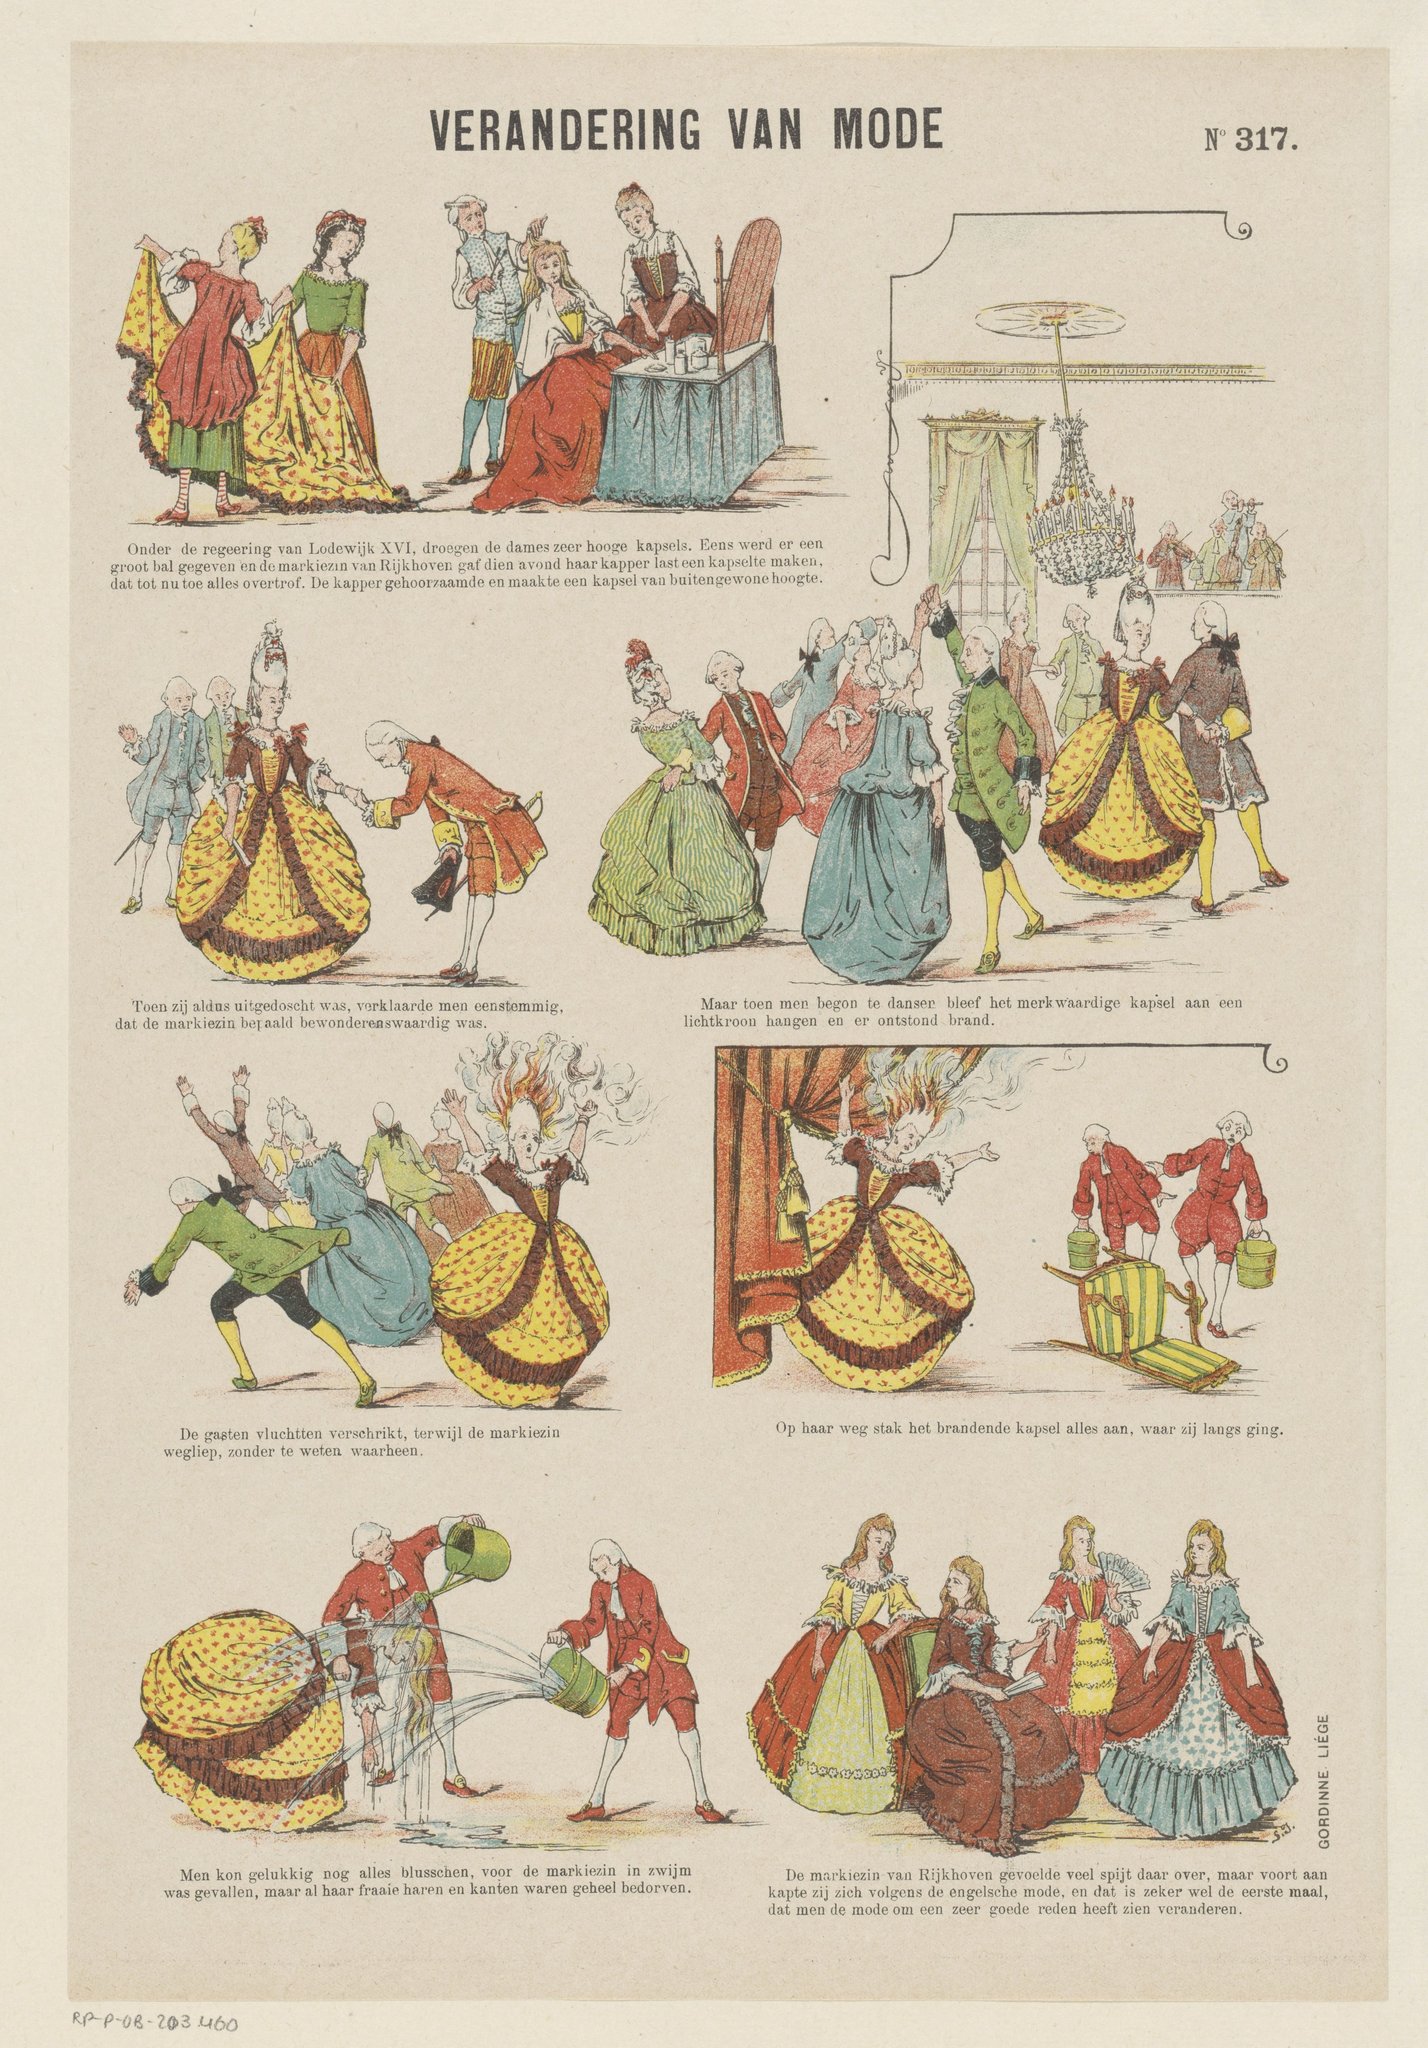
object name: popular print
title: Verandering van mode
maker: monogrammist g.j.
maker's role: print maker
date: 1894-1959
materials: paper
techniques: lithograph, letterpress printing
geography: liège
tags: fashion, clothing, on fire, ablaze, wig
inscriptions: collector's mark: Lugt 2760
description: Blad met 7 voorstellingen over de hoge pruik van de markiezin van Rijkhoven die in brand vliegt. Onder elke afbeelding een onderschrift. Genummerd rechtsboven: No 317.